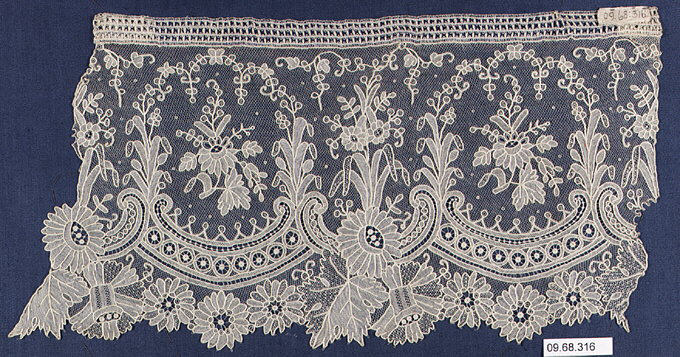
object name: specimen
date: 1801-1900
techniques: lace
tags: flowers